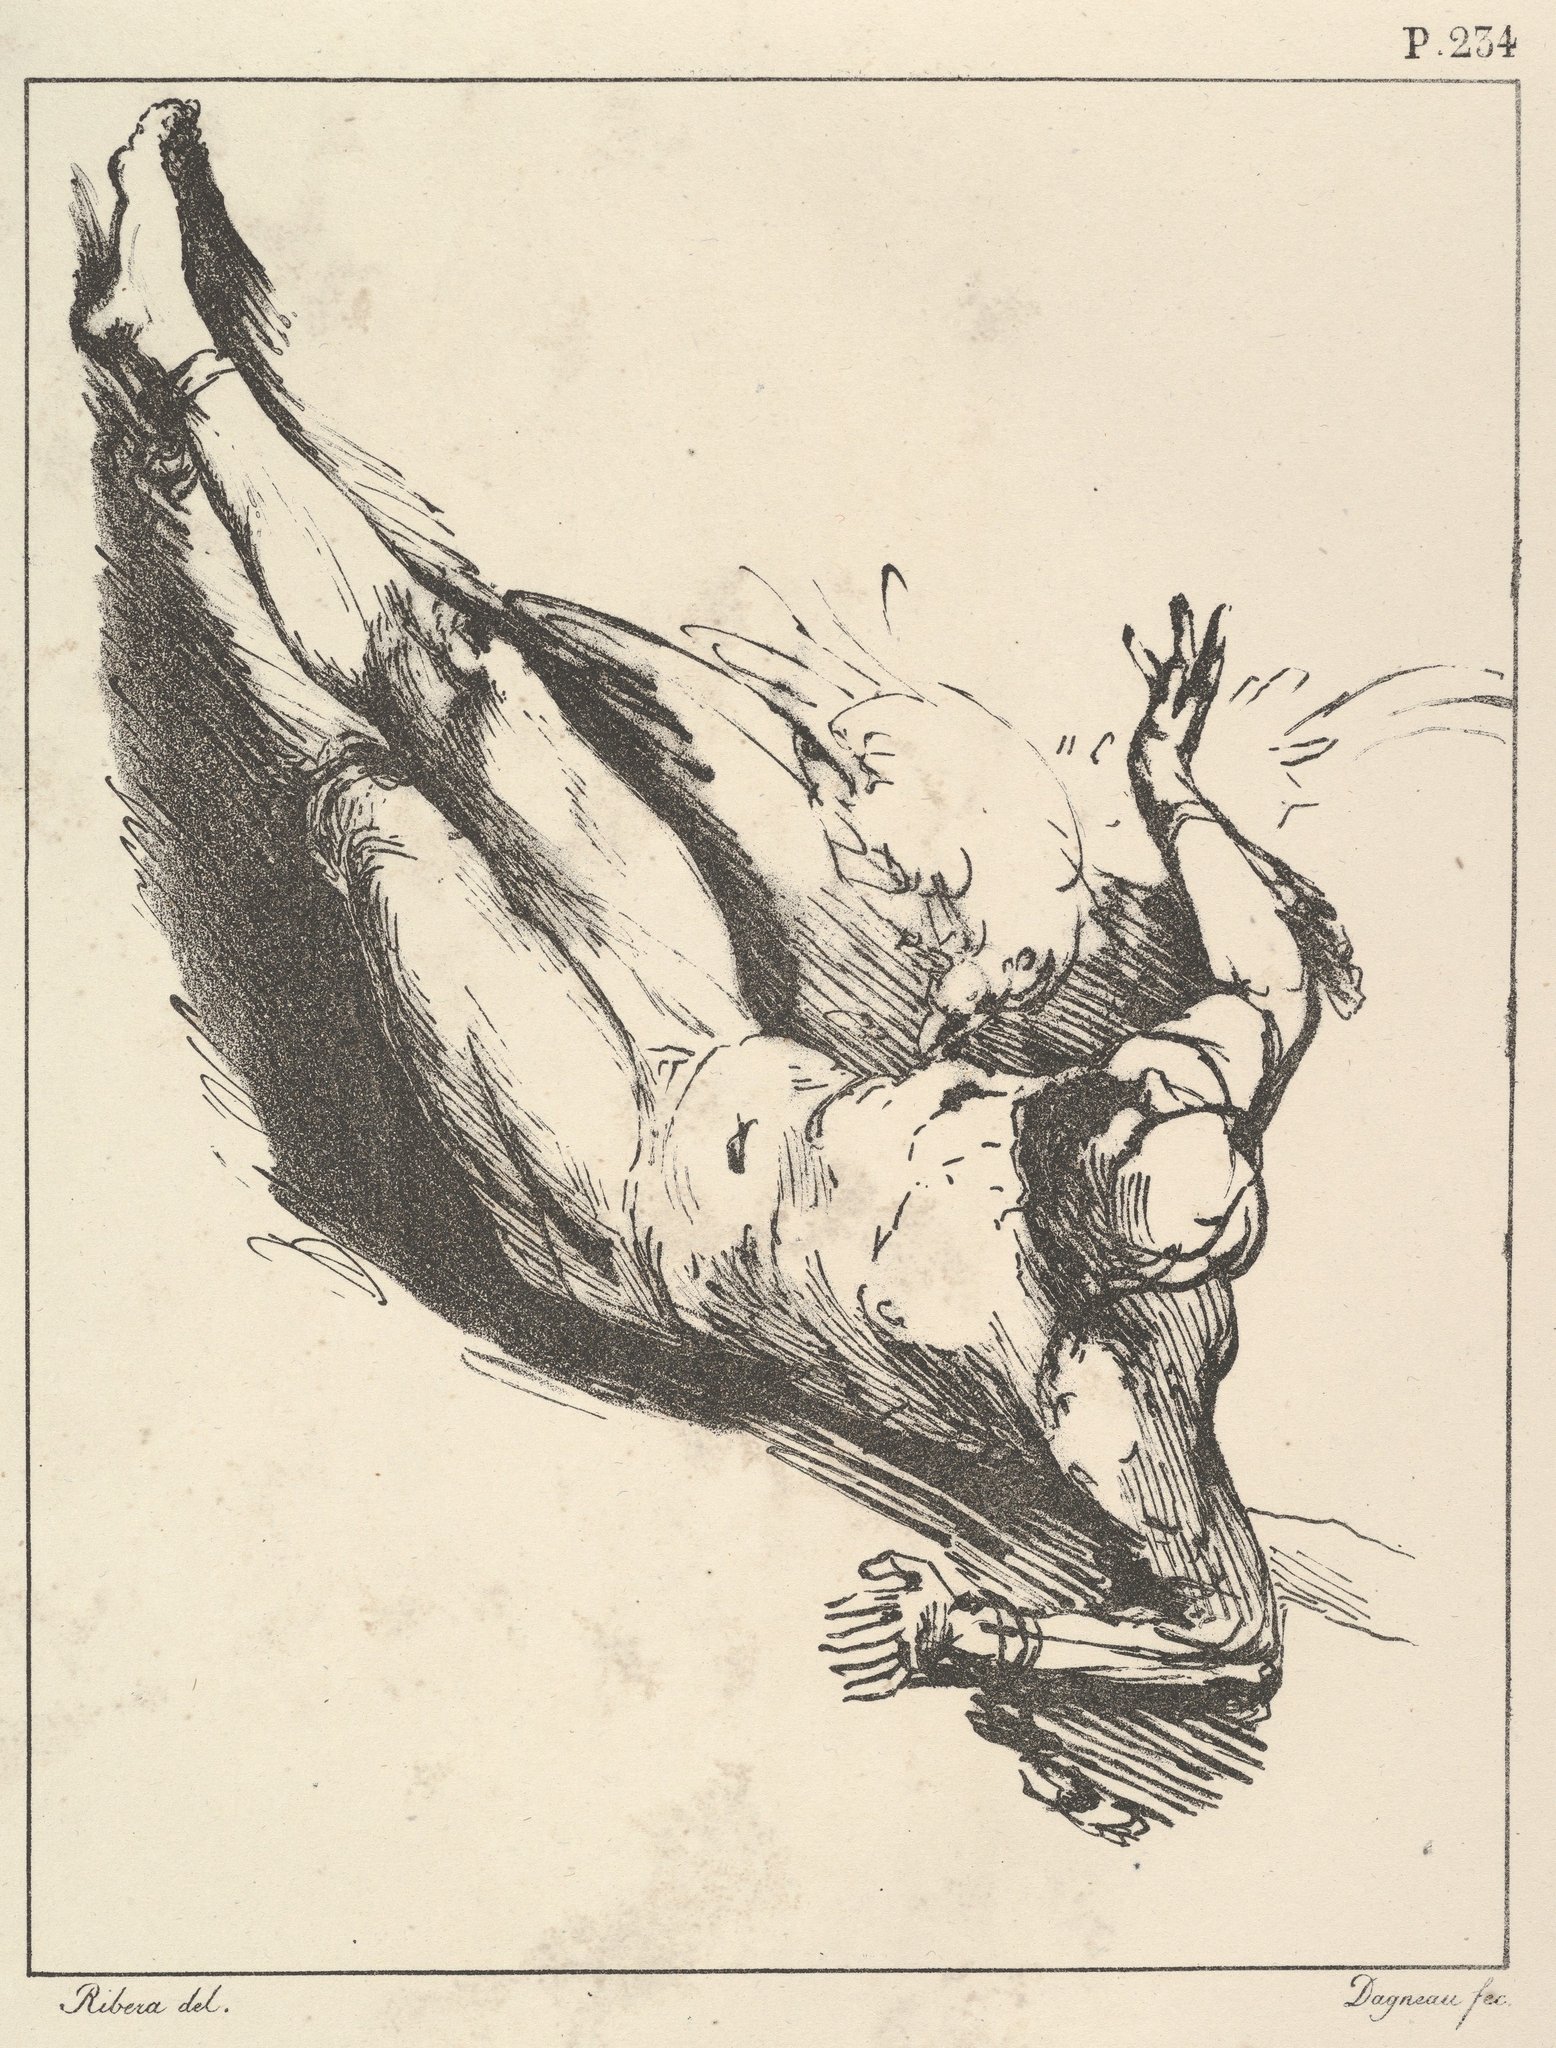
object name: print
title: Prometheus chained, two pendentives and an Egyptian Saint Marie, volume 3, plate 234 from "Monuments des Arts du Dessin"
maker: jules dagneau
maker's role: artist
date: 1829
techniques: lithograph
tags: male nudes